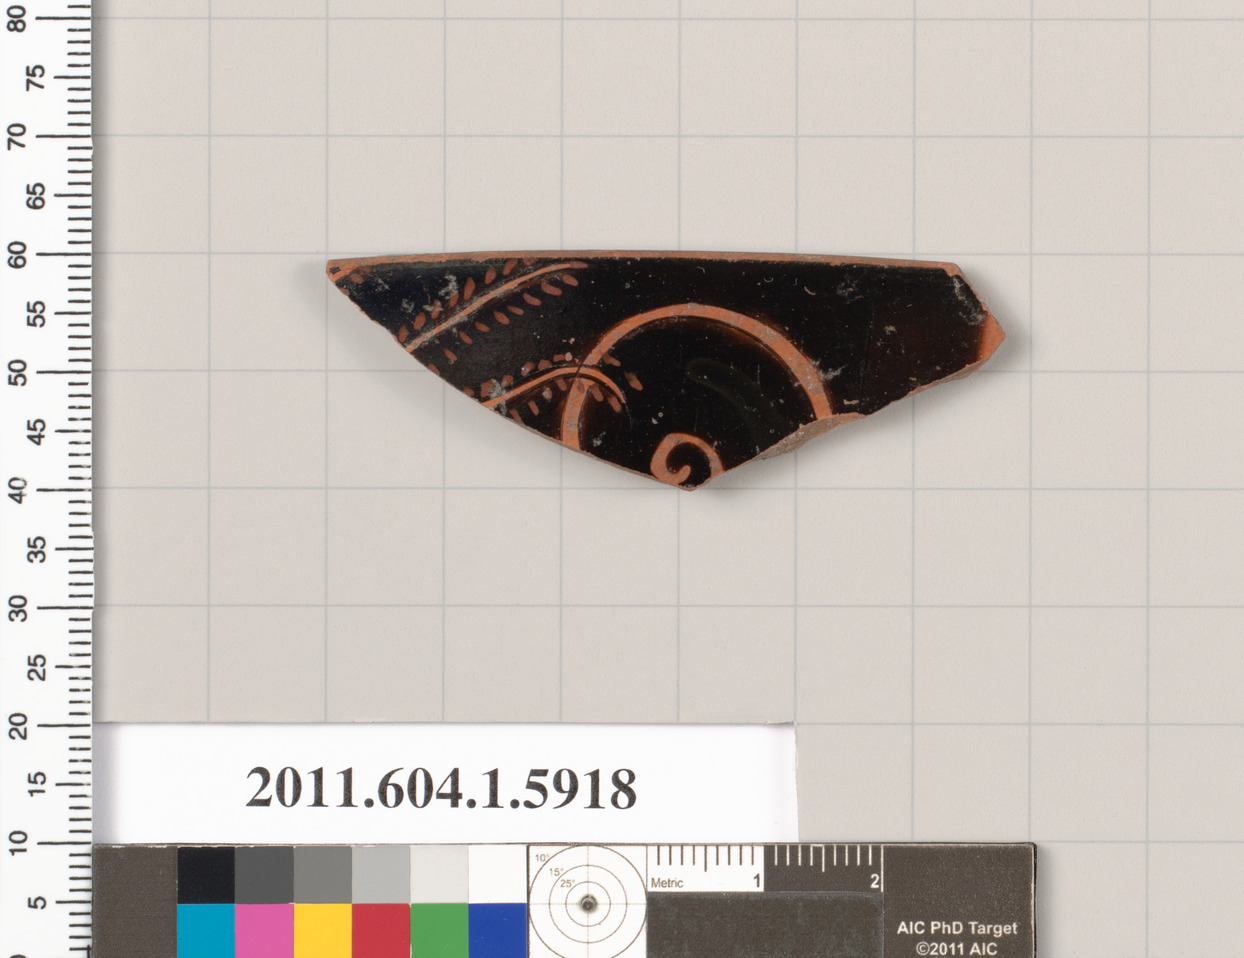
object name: kylix fragment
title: Terracotta rim fragment of a kylix (drinking cup)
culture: greek, attic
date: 520-510 BCE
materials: terracotta